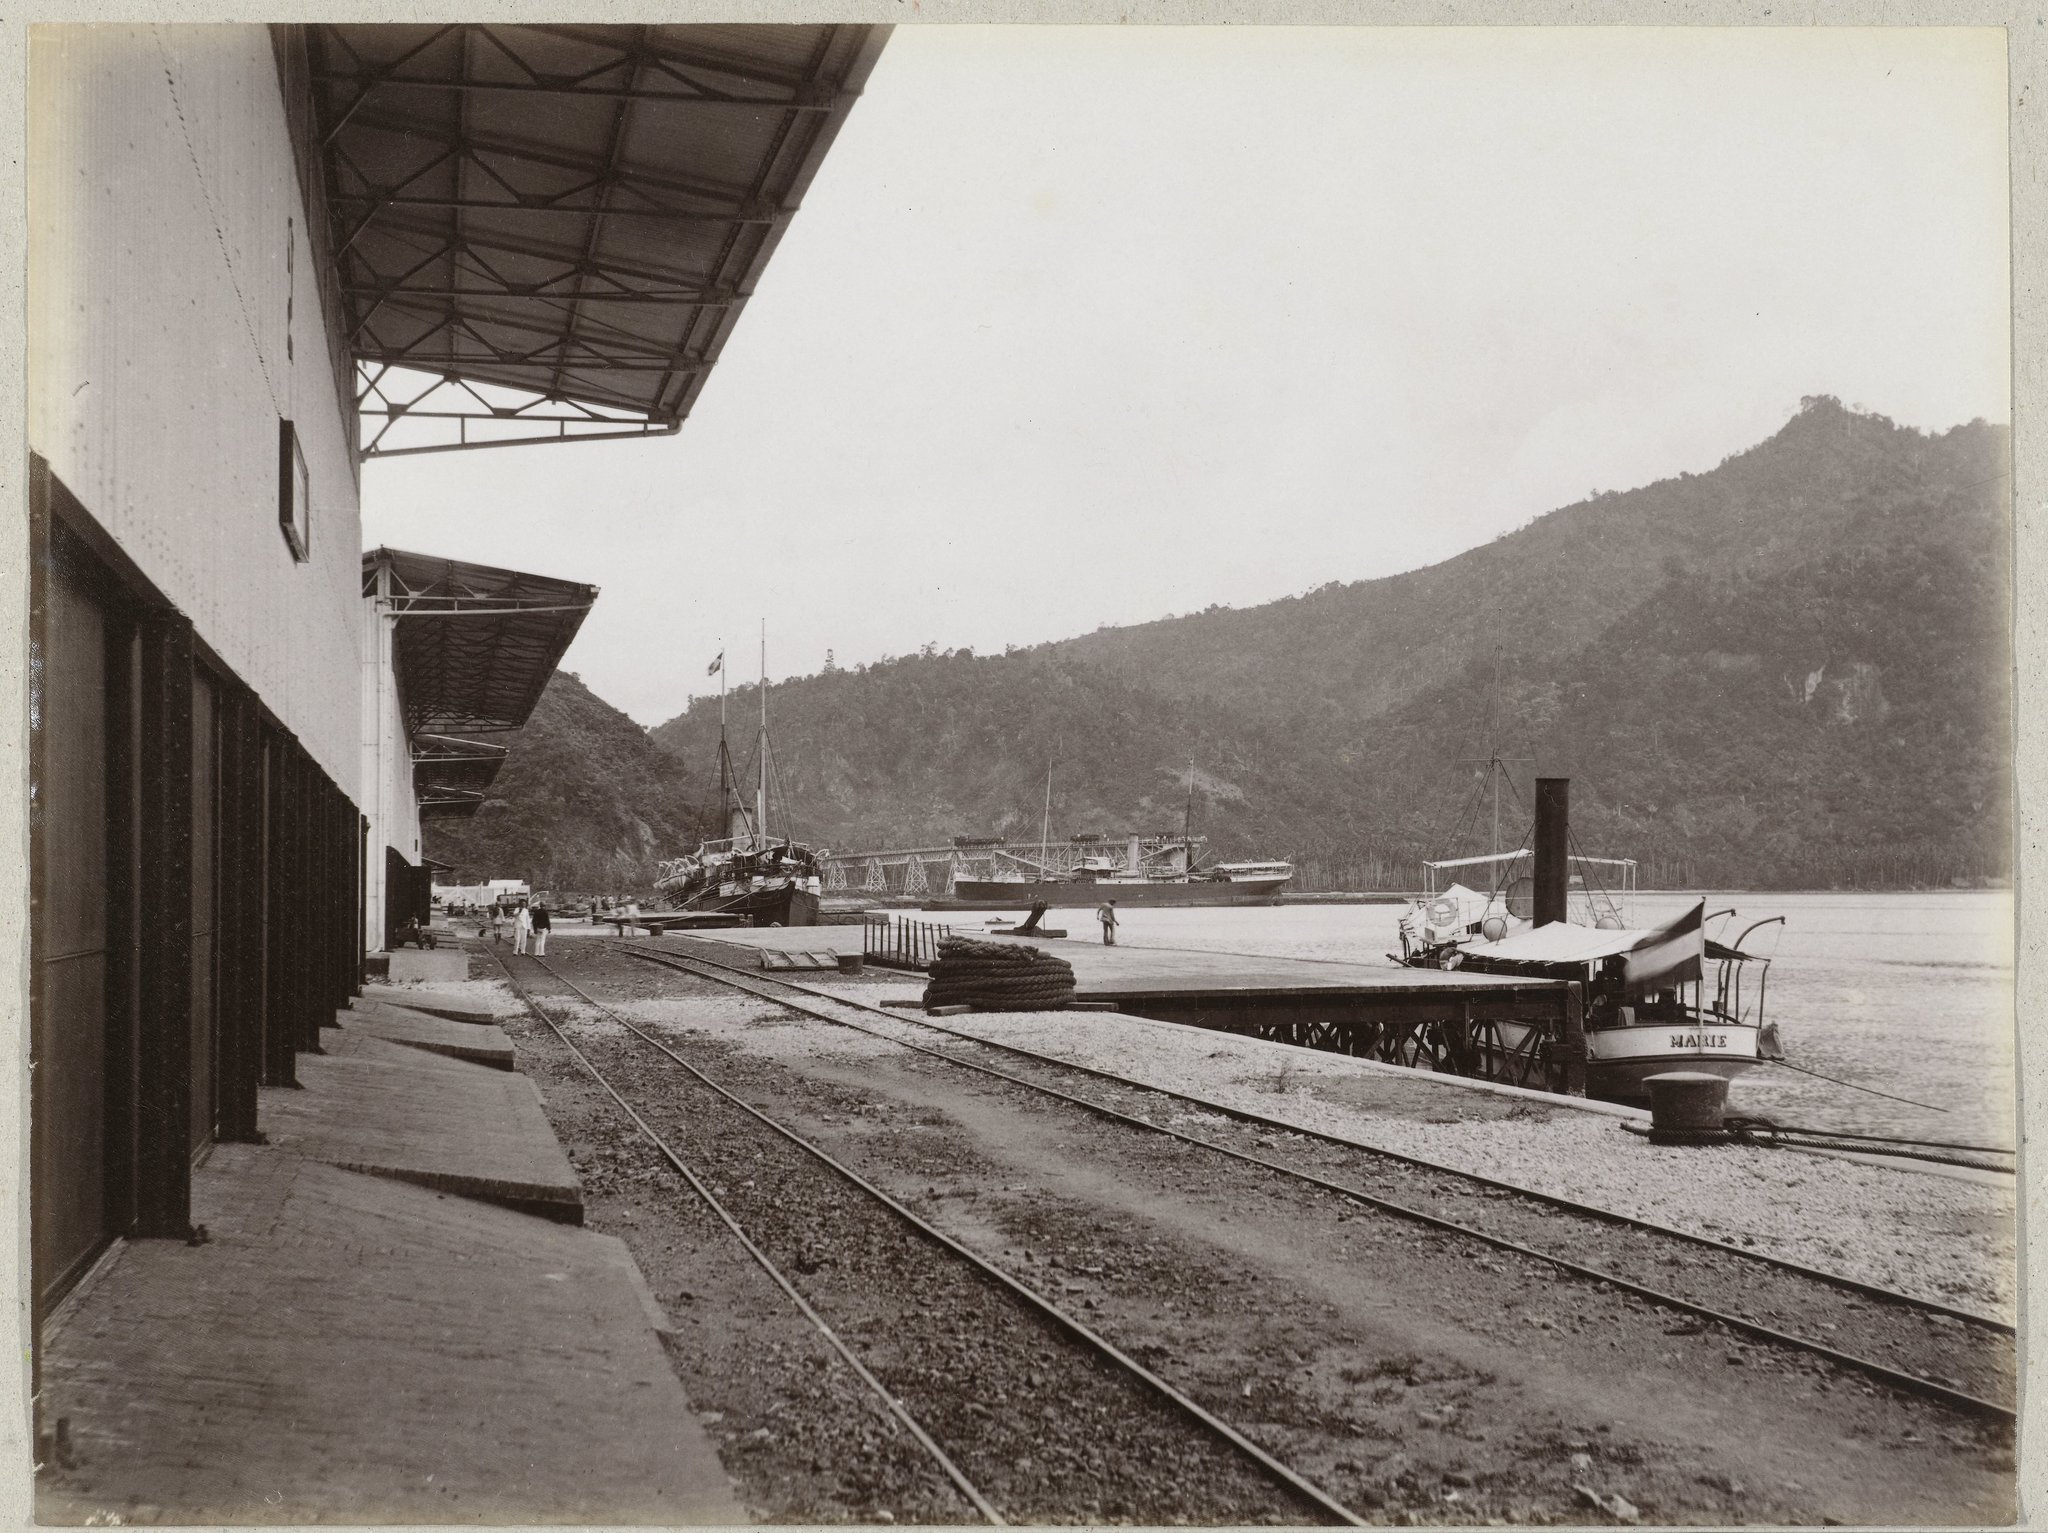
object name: photograph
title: Rede van de Emmahaven in Padang op Sumatra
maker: christiaan benjamin nieuwenhuis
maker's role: publisher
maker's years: 1863-1922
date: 1891-1912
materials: paper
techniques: albumen print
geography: padang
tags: harbour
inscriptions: inscription: ‘Emmahaven’